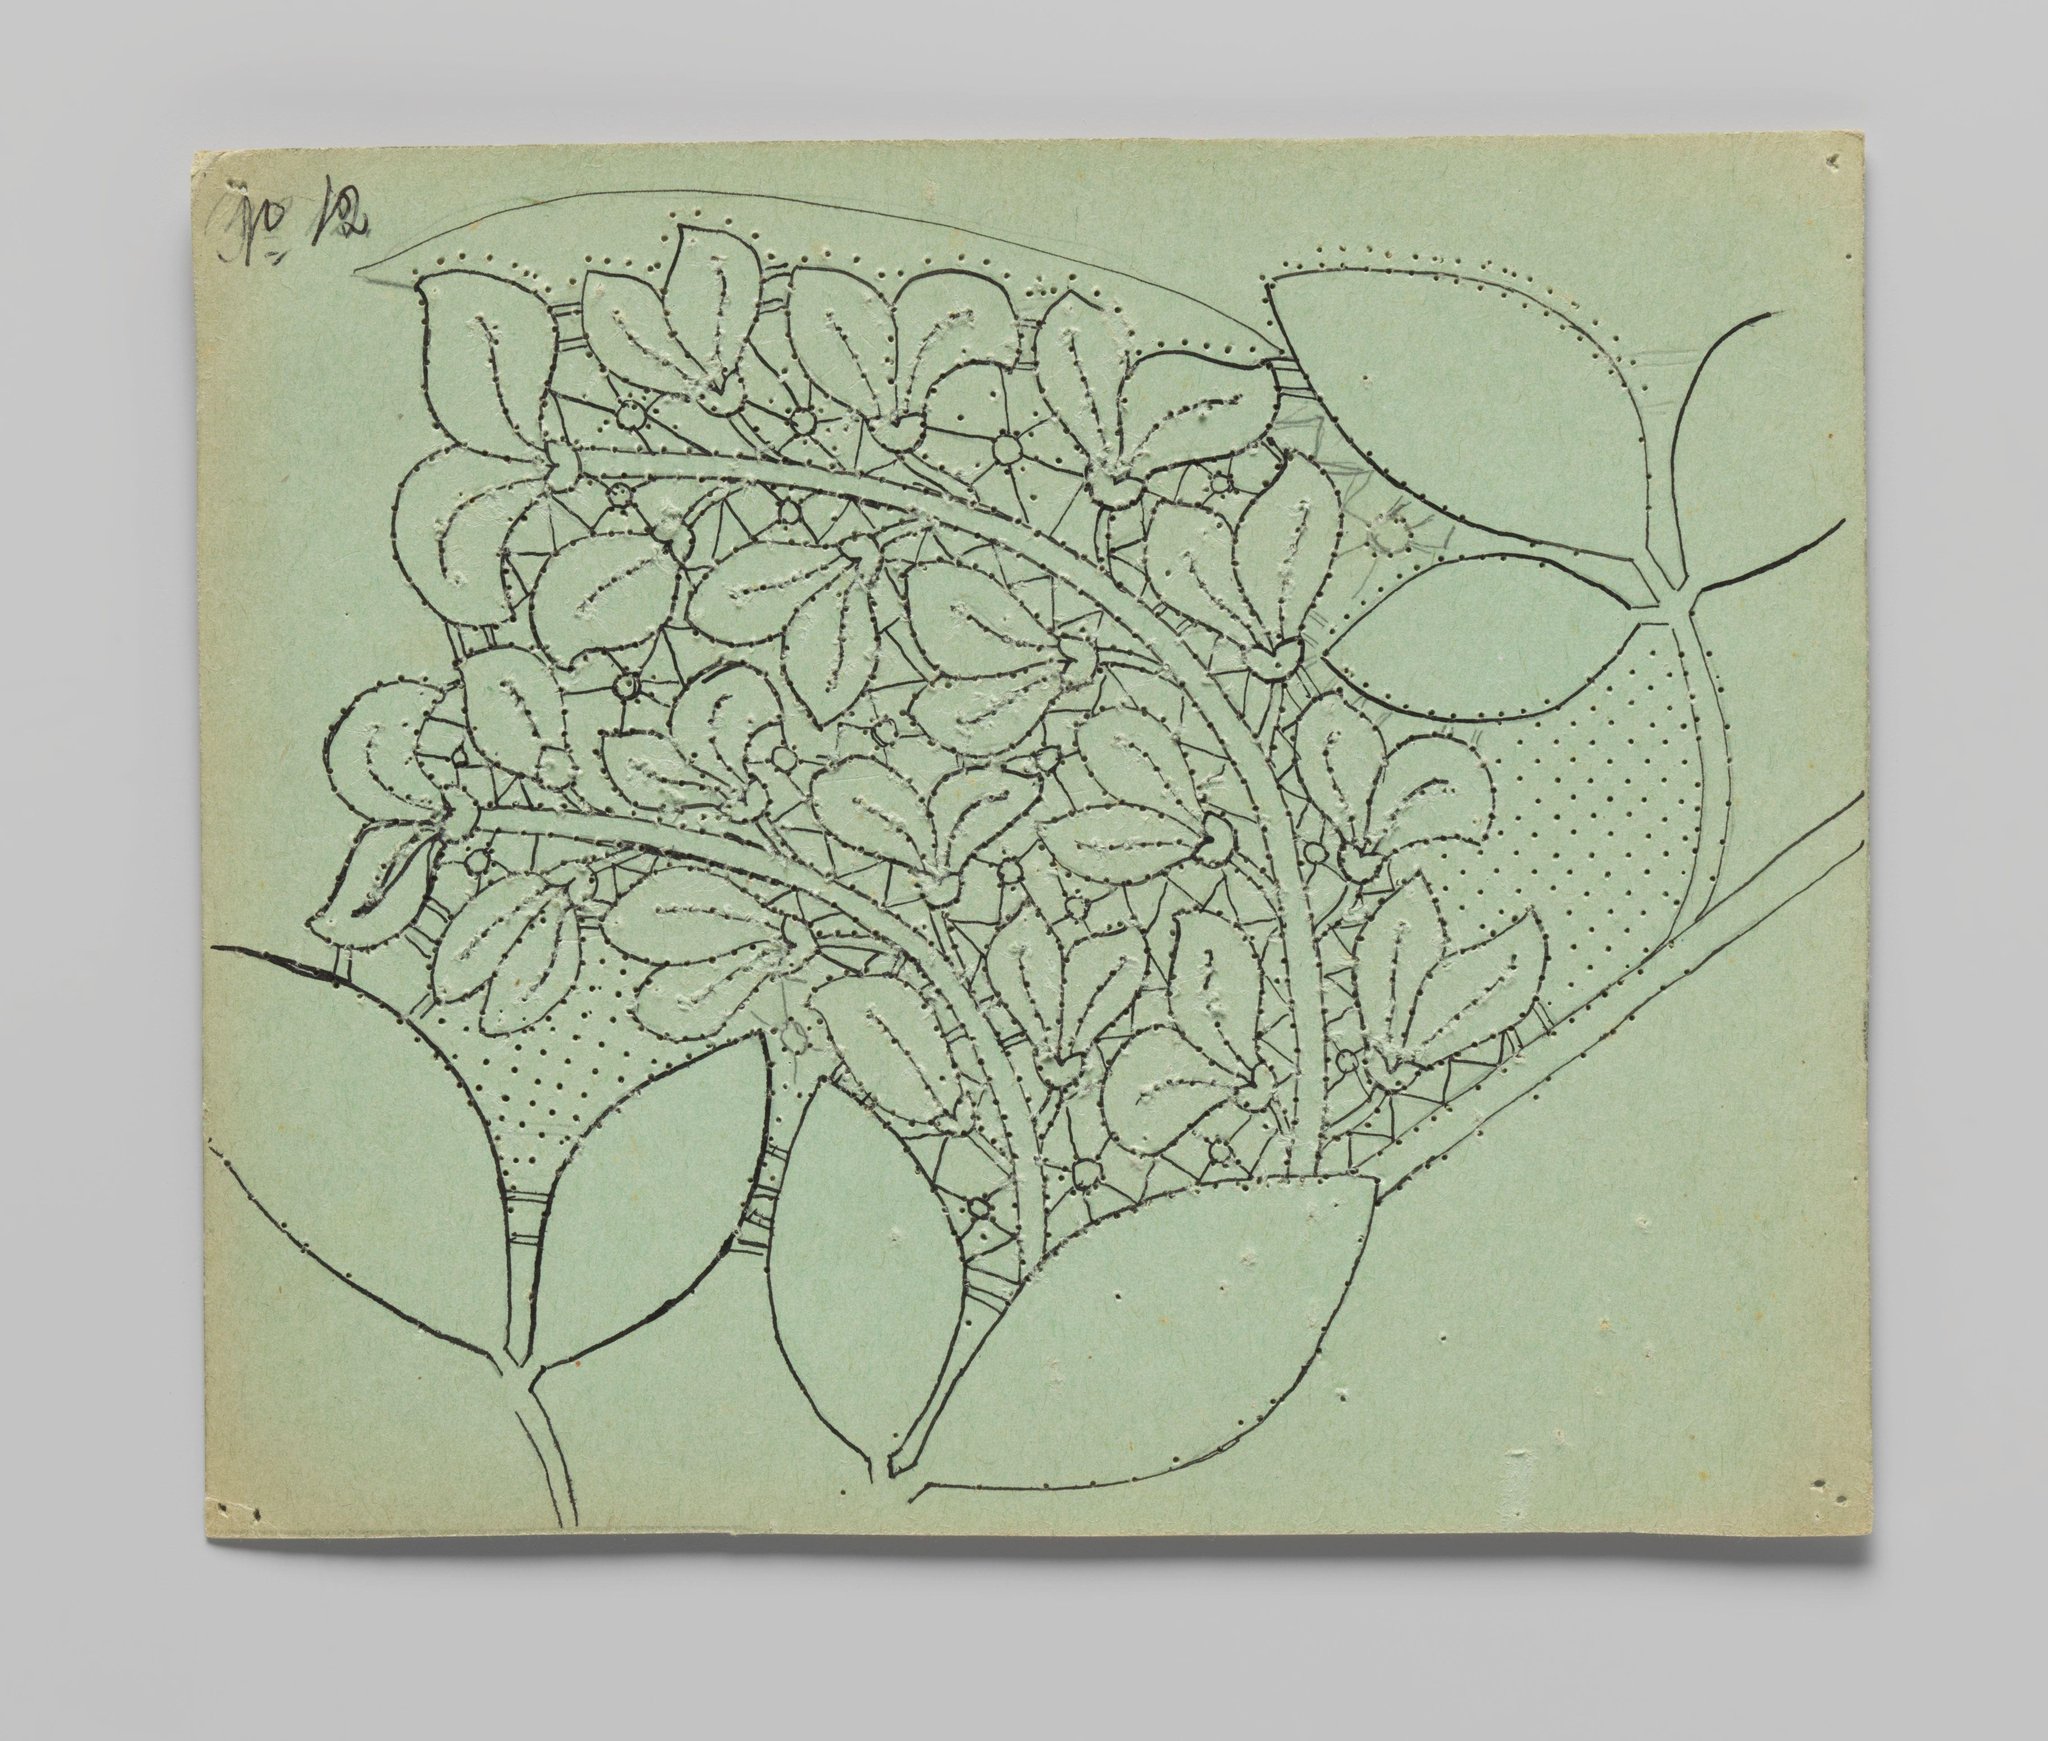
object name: lace pattern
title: Kantpatroon voor een kleed van kloskant met goudenregentakken en -bloemen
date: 1912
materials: paper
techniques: drawing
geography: apeldoorn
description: Kantpatroon met een deel van het patroon voor een kleed met invnr. BK-1979-84. De brief is genummerd (12).